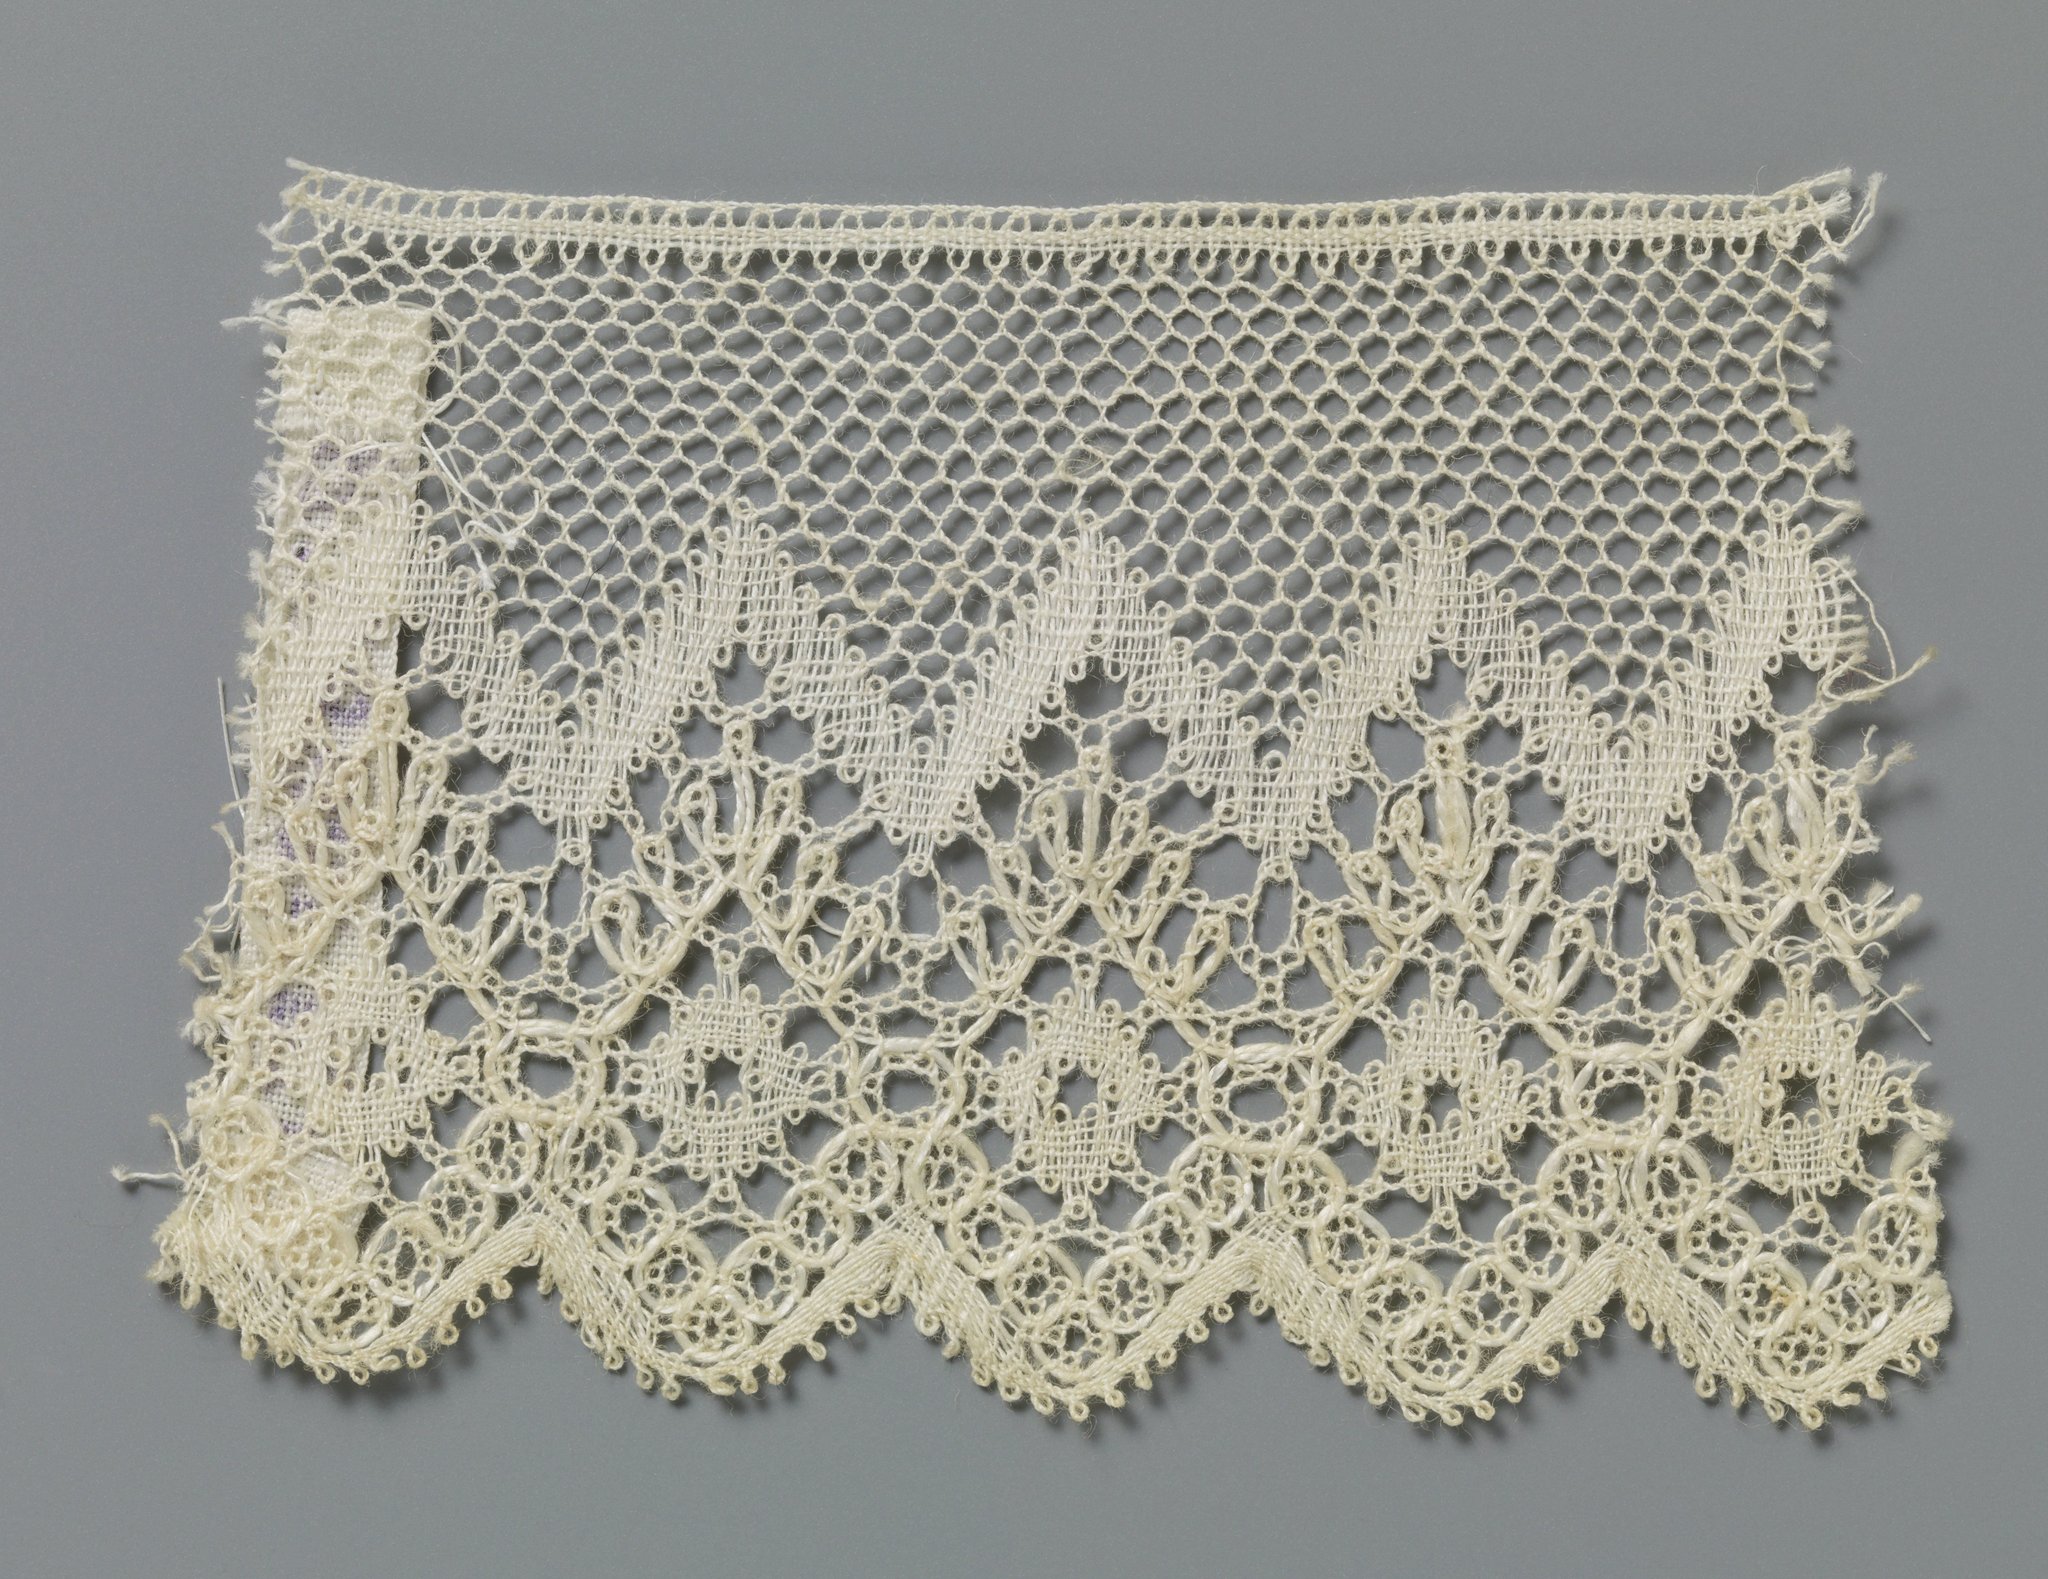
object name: strip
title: Strook kloskant met ruiten onder zigzag-lijn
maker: Anonymous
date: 1800-1899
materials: cotton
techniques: lace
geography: buckingham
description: Strook naturelkleurige kloskant, Buckingham-kant. Het zich herhalende patroon bestaat iets boven de middenlijn van de strook uit een zigzag-lijn, met daaronder een aaneenschakeling van ruiten. De motieven zijn aan de bovenzijde met elkaar verbonden door een maasgrond, een tulegrond. De zigzag-lijn en het centrum van elke ruit is gemaakt in linnenslag, met een uitsparing in elke ruit. Dikke en glimmende contourdraden lopen niet direct om het volwerk heen. Ze vormen om de ruiten heen een sierband van cirkeltjes en lusjes in de rozengrond, die hier als siergrond is toegepast. De bovenzijde van de strook is recht afgewerkt. De schulpenrand langs de onderzijde is afgewerkt met picots.